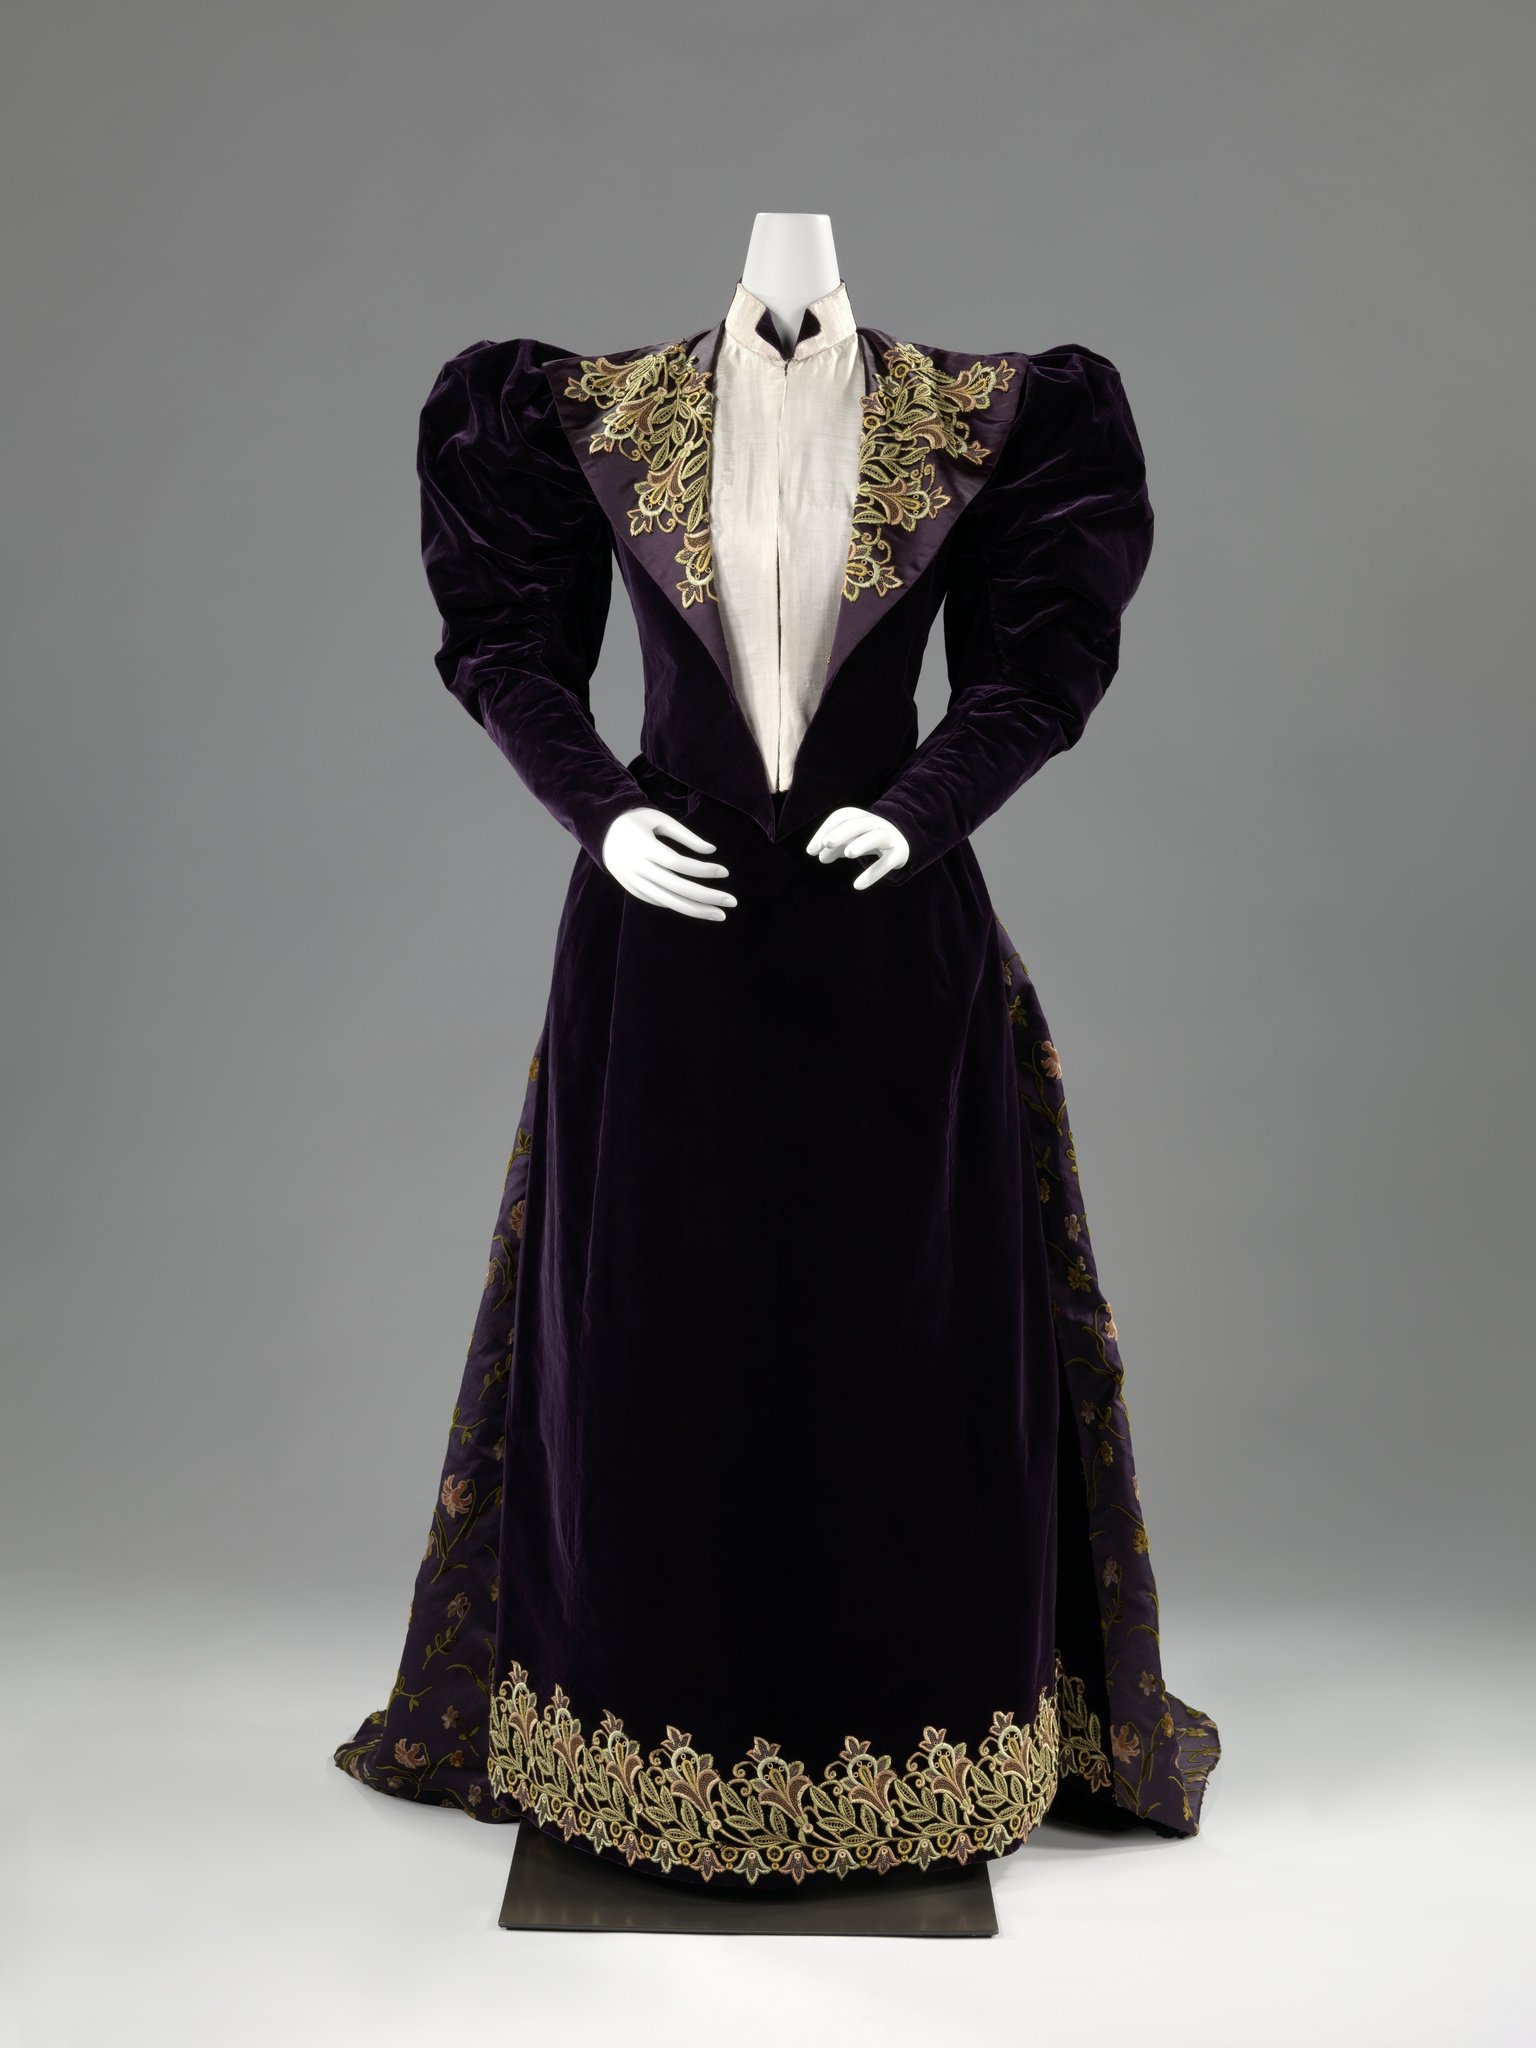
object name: main garment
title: Lijf met schapeboutmouwen, van paars fluweel en paarse zijde met meerkleurige florale applicatie; voorstuk van lichtpaarse zijde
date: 1893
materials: silk, velvet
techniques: appliqué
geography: amsterdam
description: Lijf horend bij een japon van paars fluweel. Lange mouwen. Rug waarvan het middenpand versierd is met passement geappliceerd in roze, gele en groene kleuren. De beide andere panden en zijpanden zijn van paarse zijde met opgeweven fluwelen bloemtakken. Het fluwelen voorpand met aangeknipte revers zijn met zijde bekleed en eveneens van passement voorzien, terwijl het middenvoorstuk van lichtpaarse zijde is gemaakt. Voering van crême-satinet.